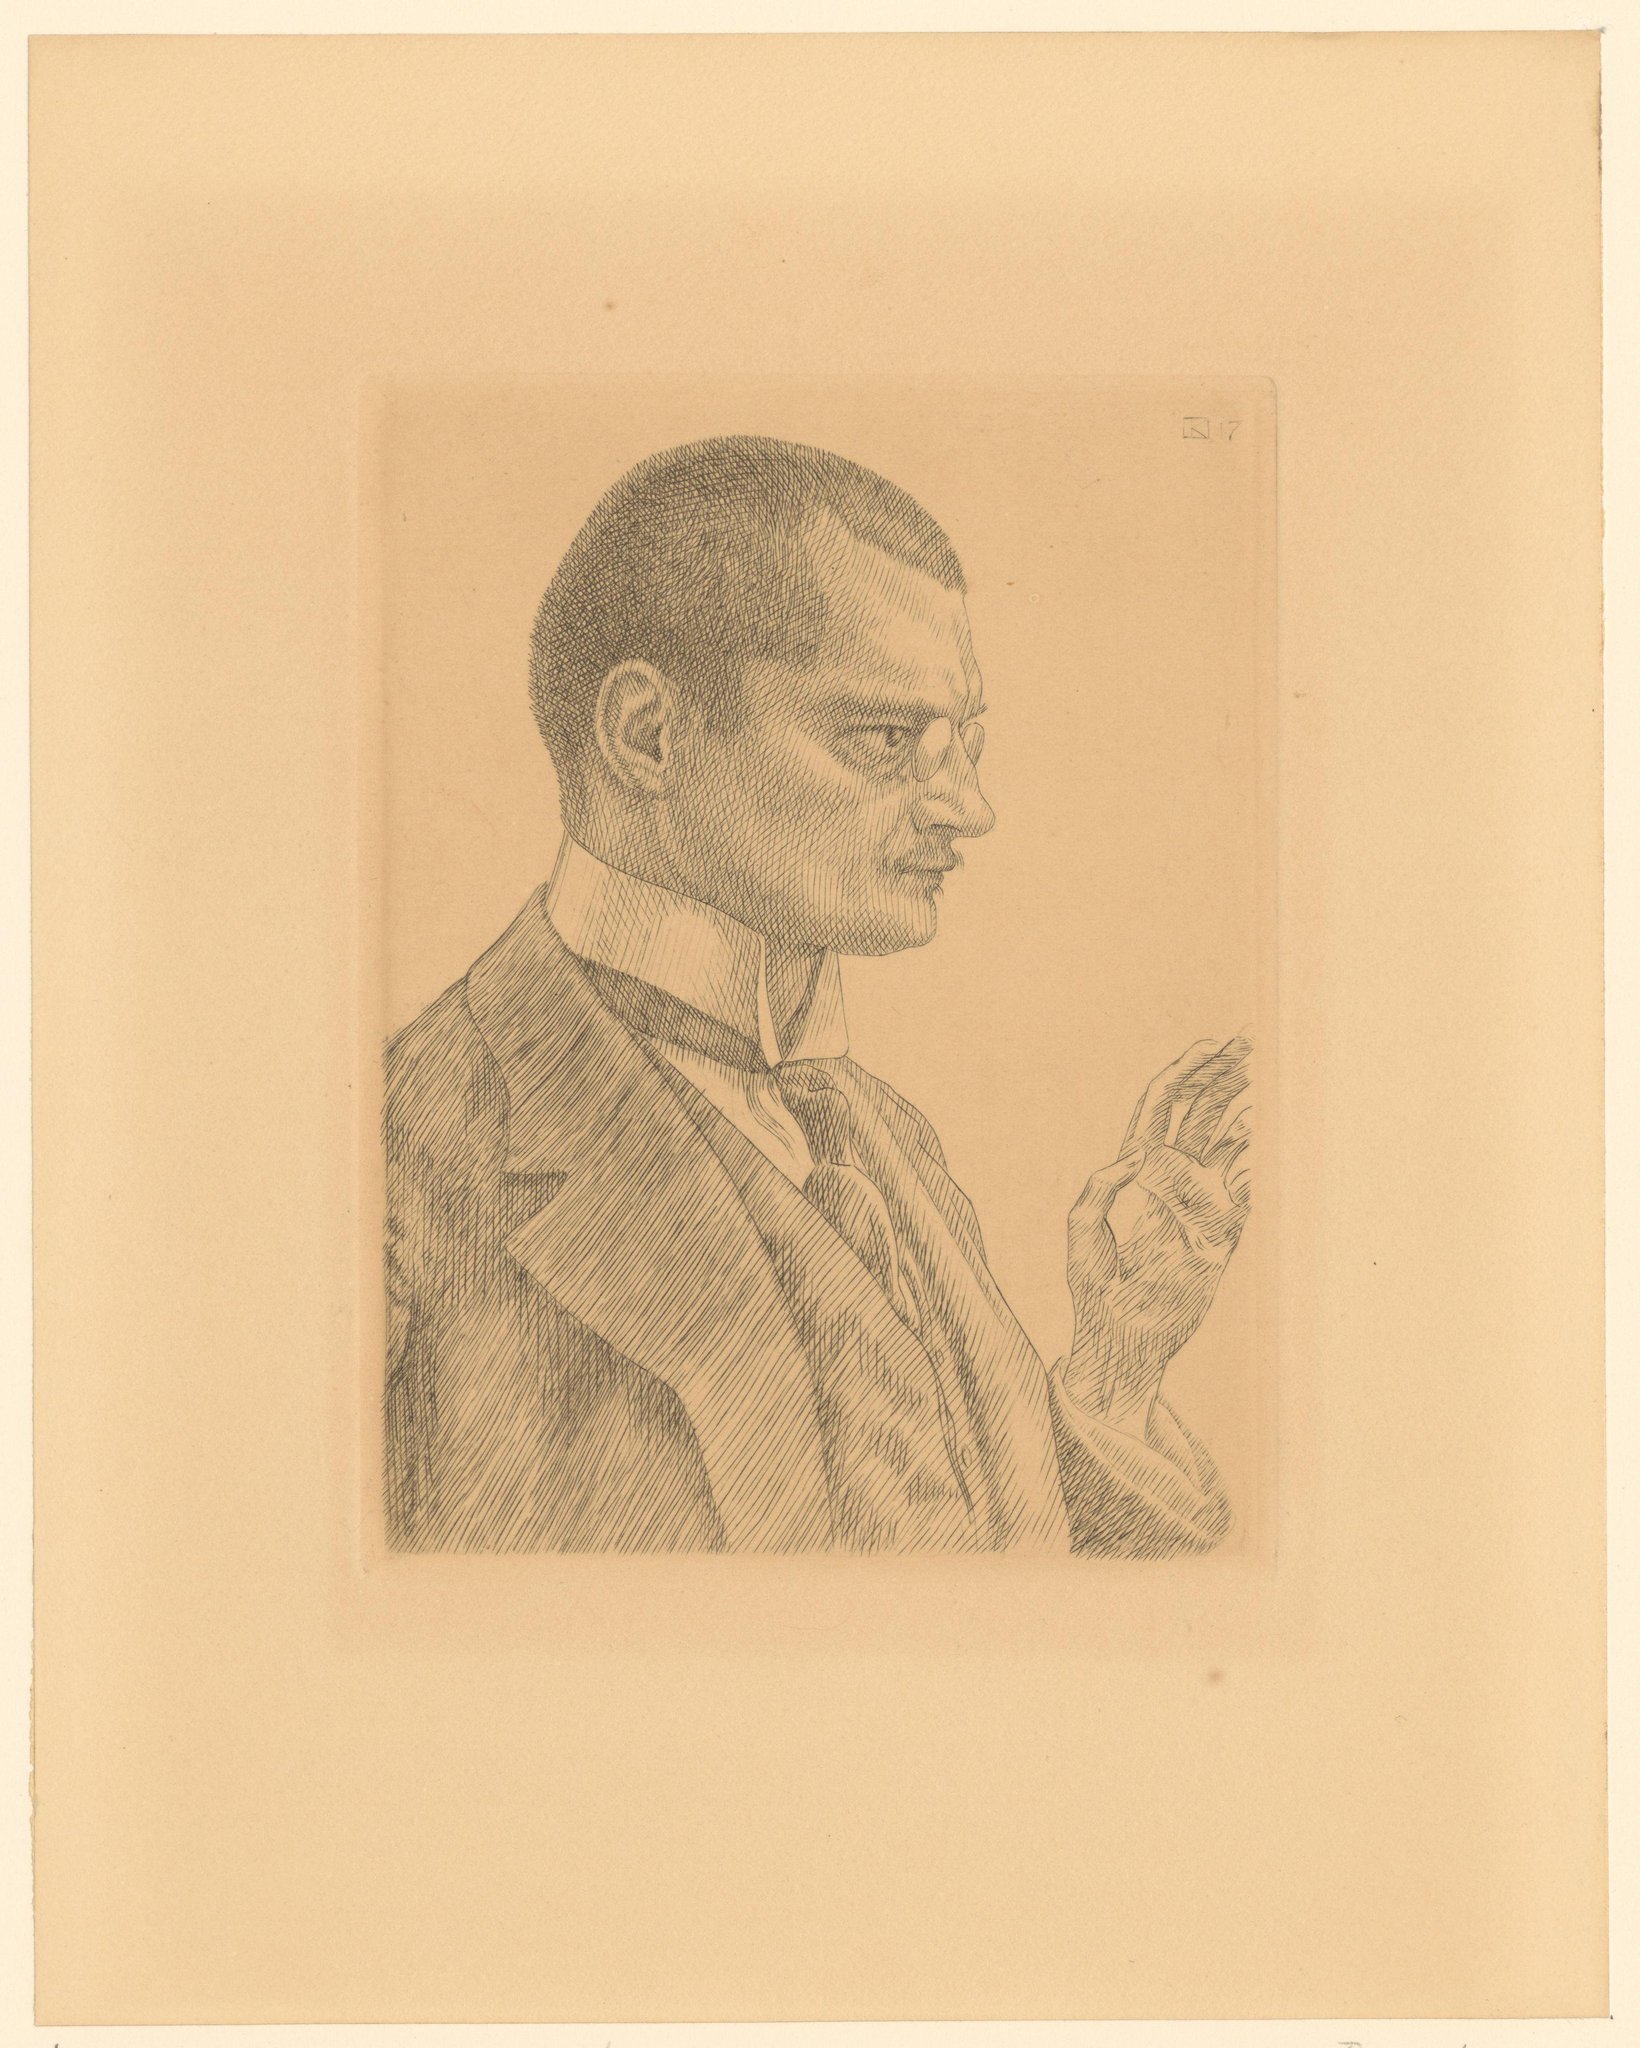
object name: print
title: Portret van Franz Wilhelm Koenigs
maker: leopold von kalckreuth (graaf)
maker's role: print maker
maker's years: 1855-1928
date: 1917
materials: paper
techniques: drypoint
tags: banker, historical persons, art collector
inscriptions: collector's mark: Lugt 2228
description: Franz Koenigs, getrouwd met Anna Paulina Louisa Eva Elisabeth von Kalckreuth, was de schoonzoon van Leopold von Kalckreuth.